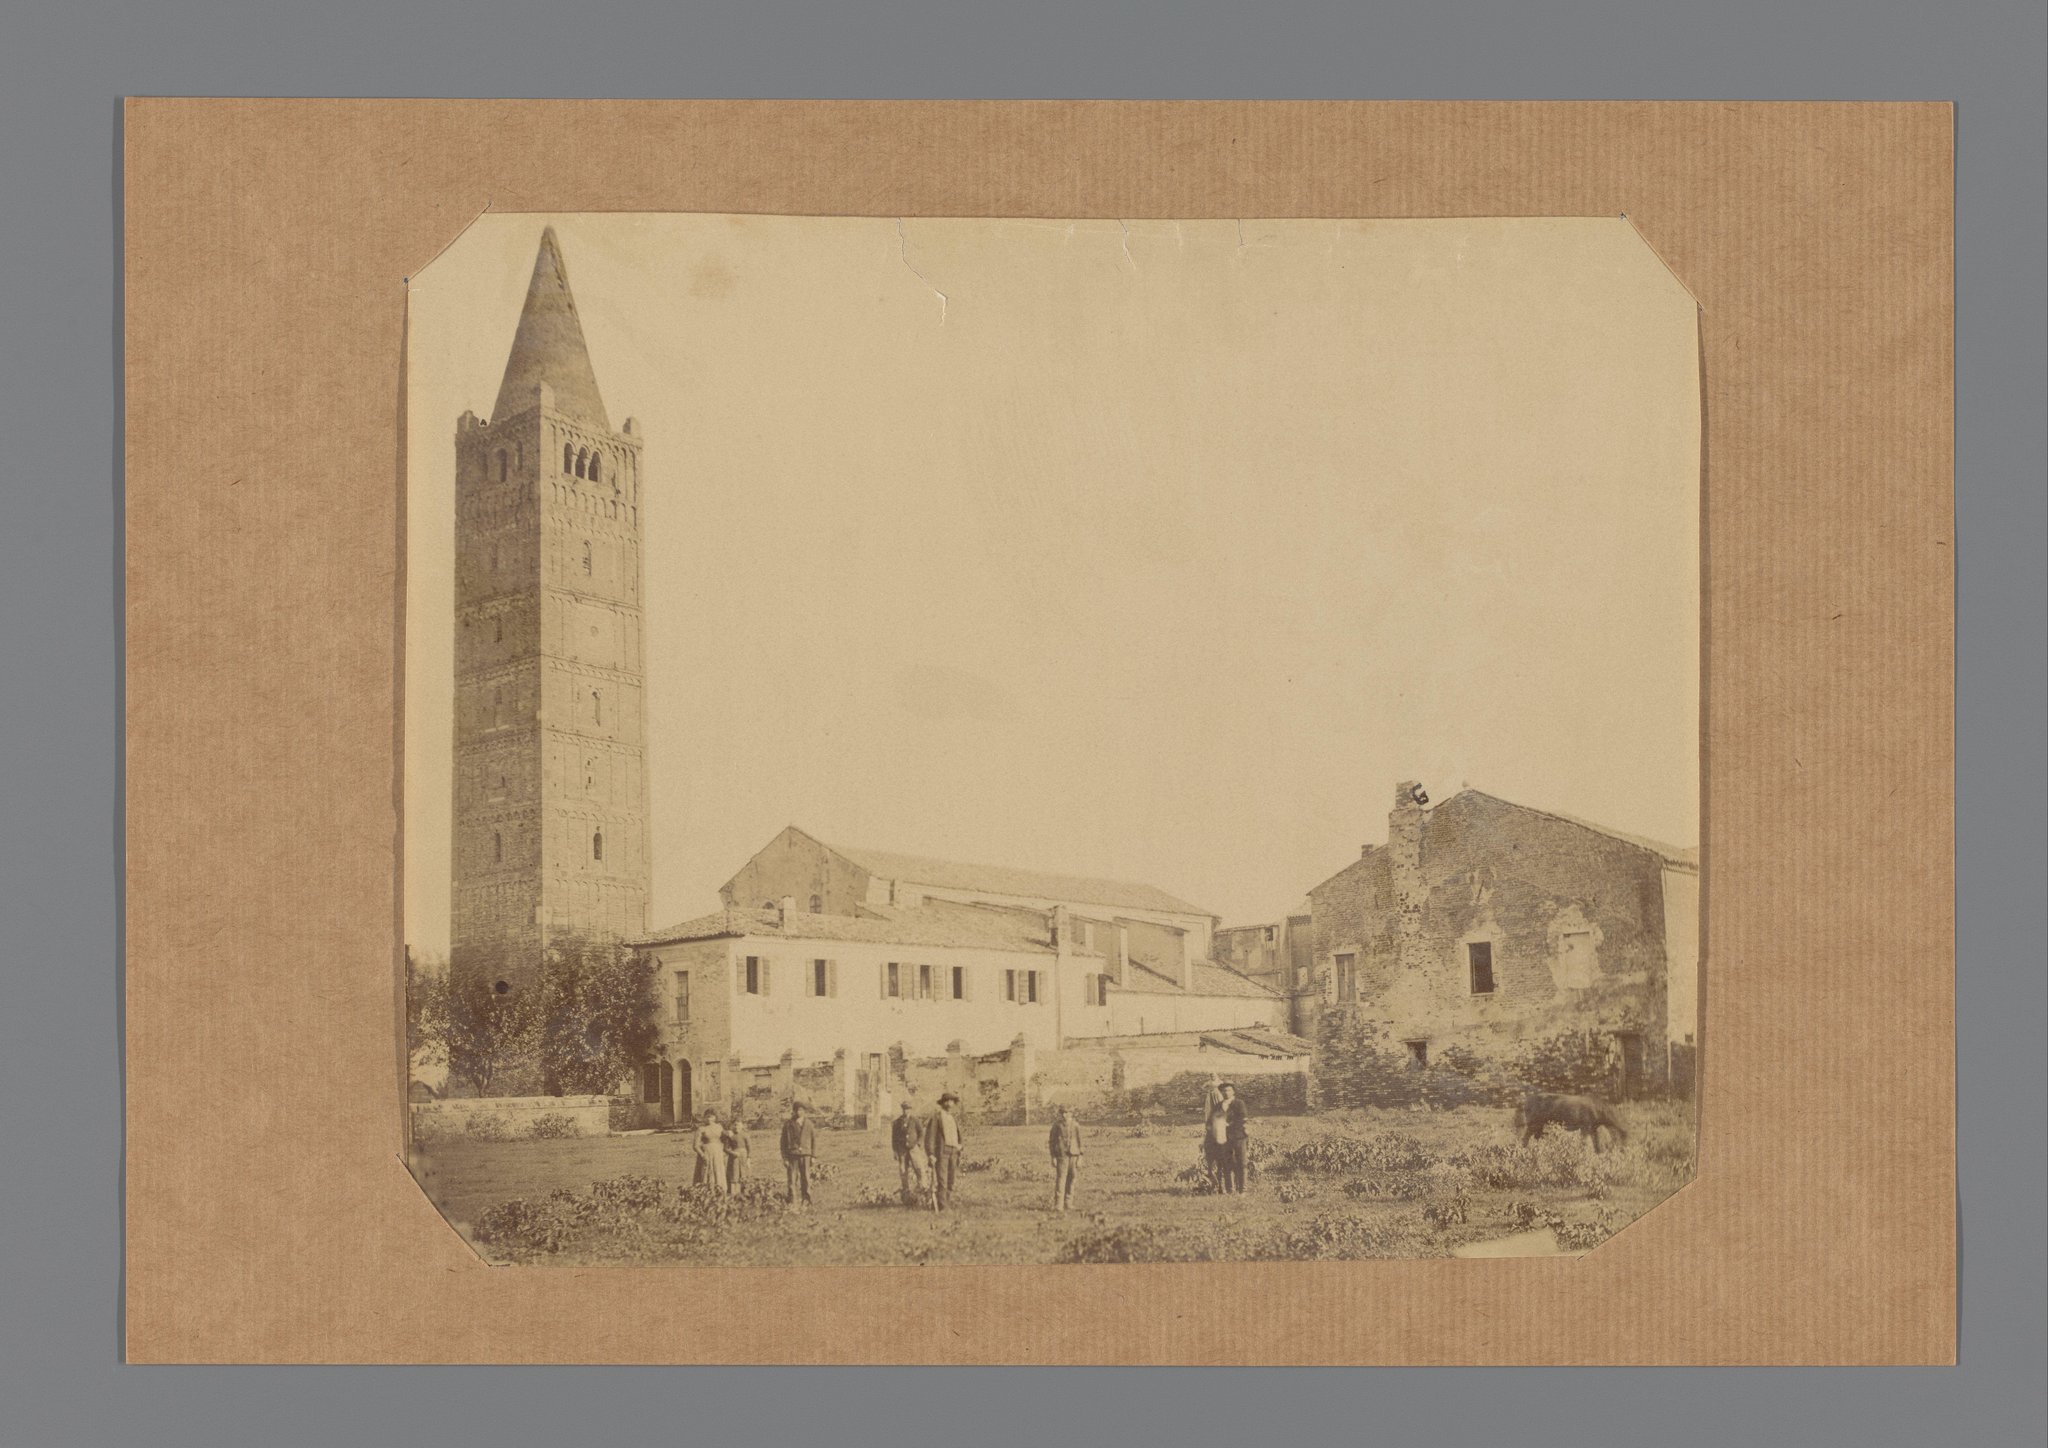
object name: photograph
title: Italië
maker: Anonymous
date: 1880-1910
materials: photographic support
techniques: albumen print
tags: italy